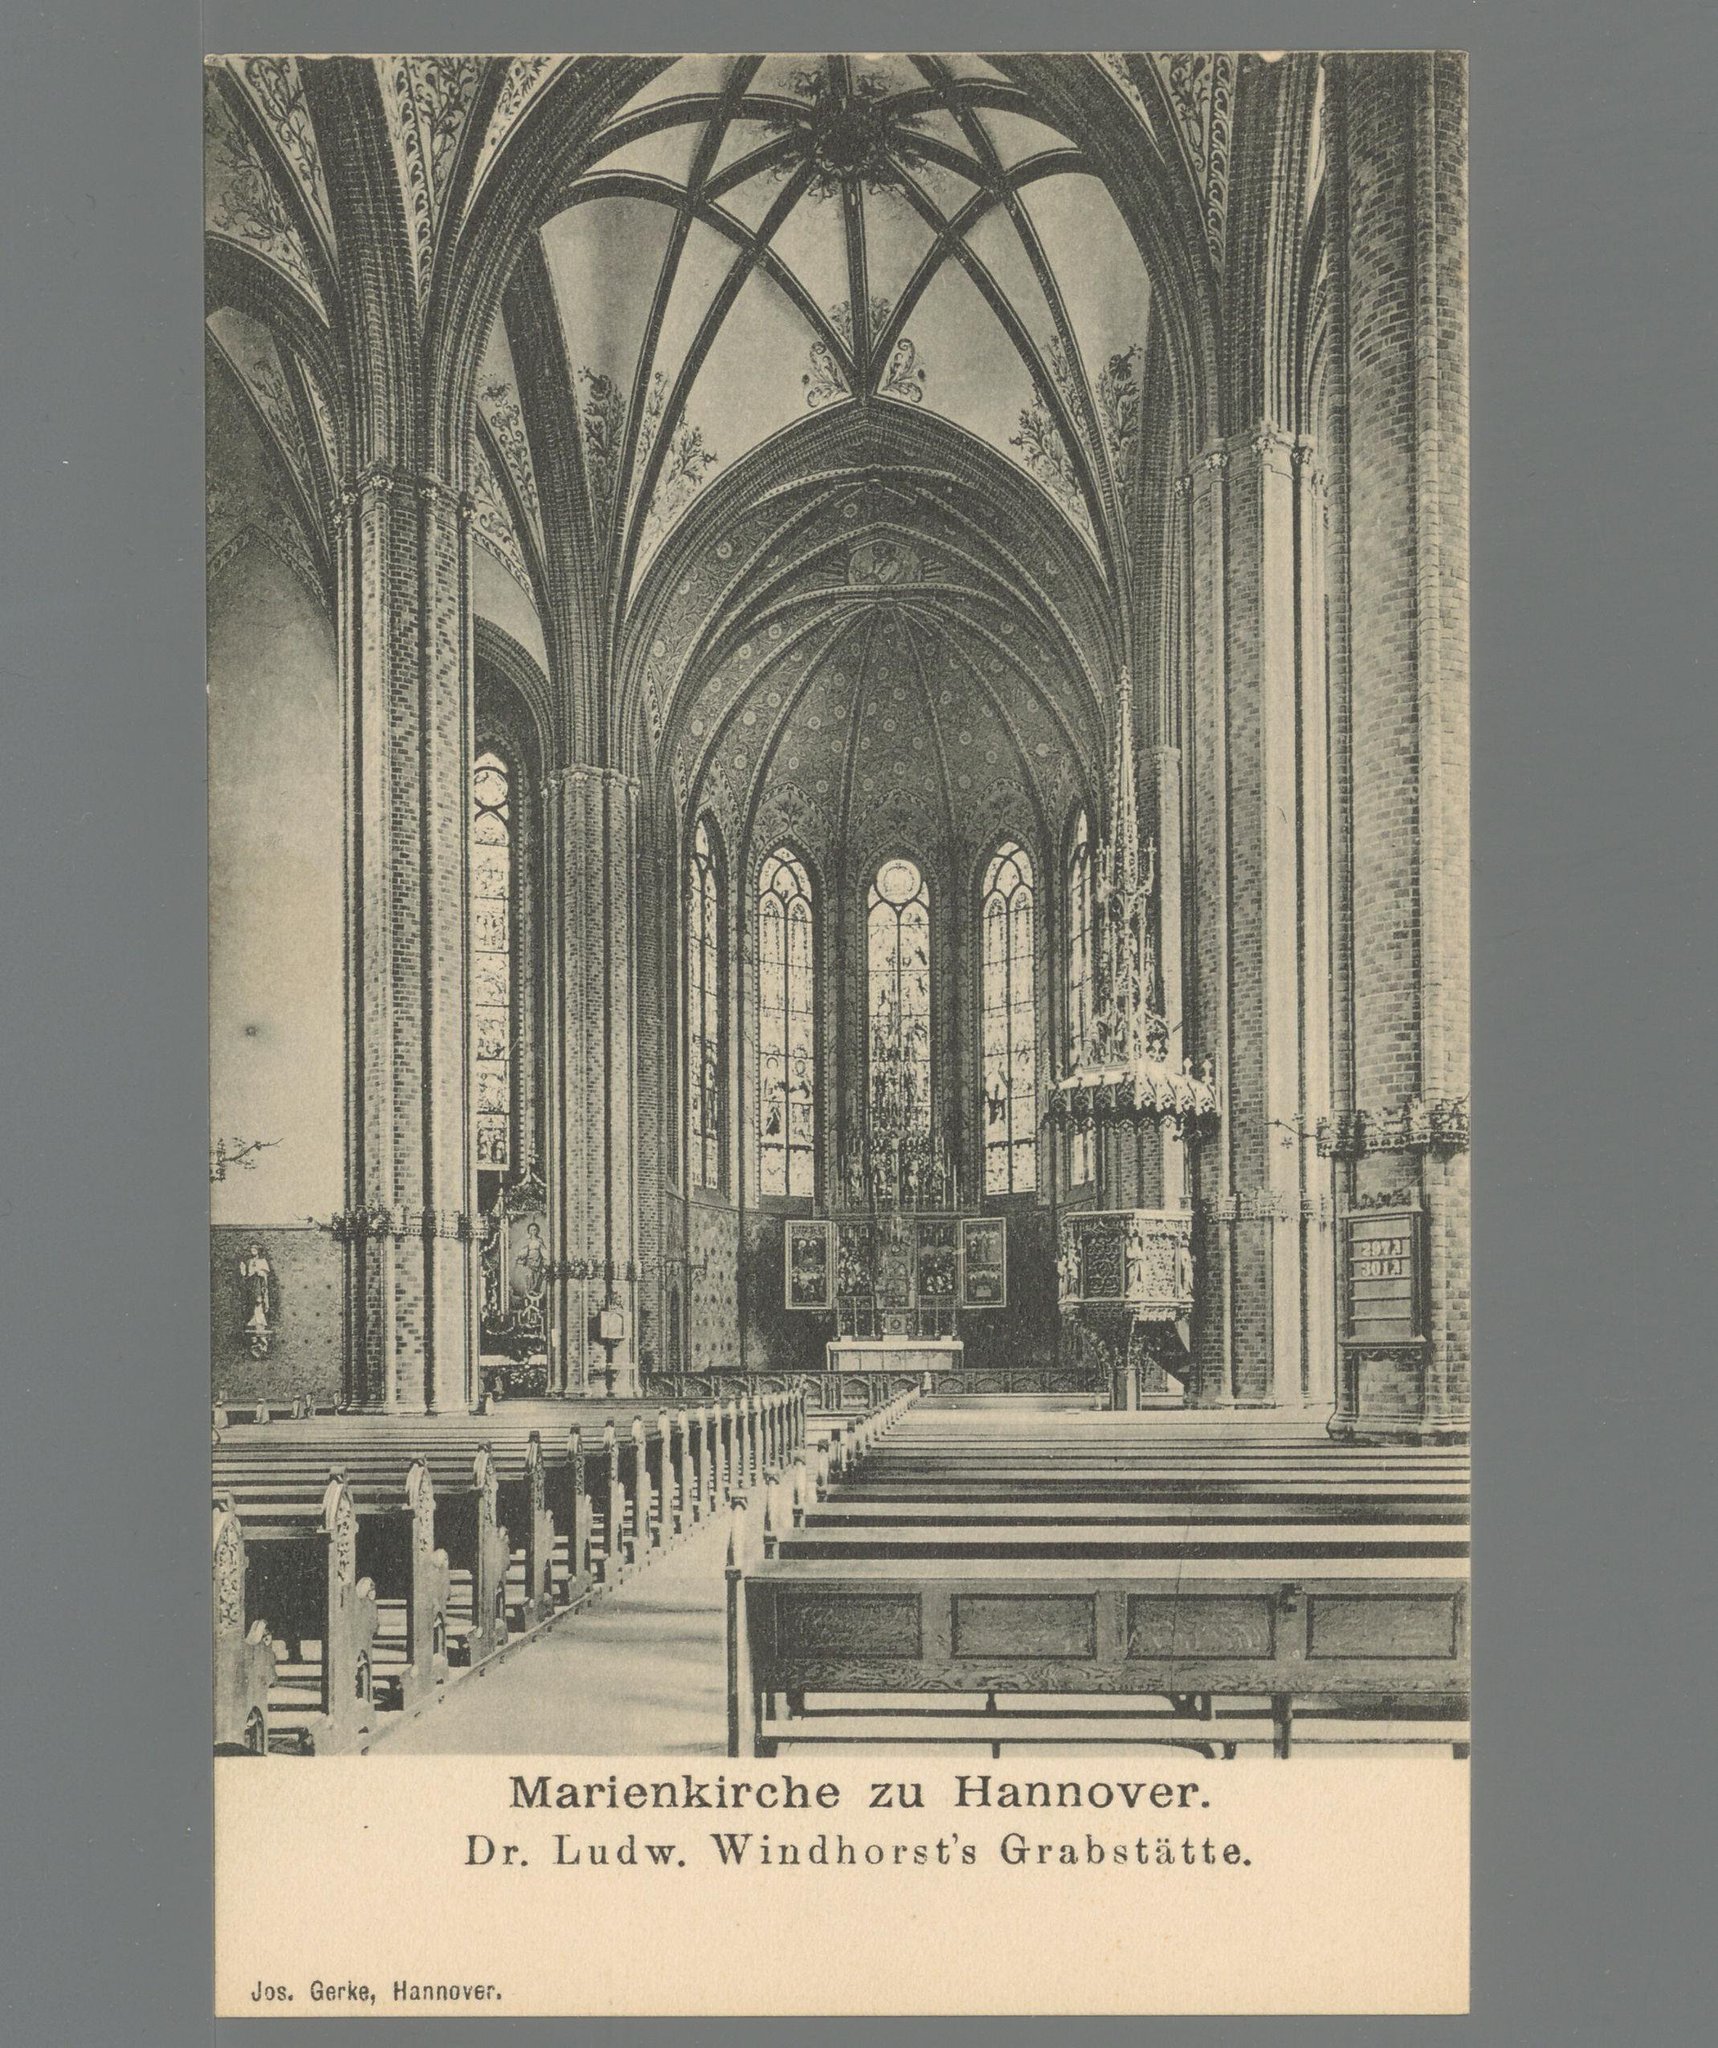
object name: ansichtkaart, prentbriefkaart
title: Marienkirche zu Hannover. Dr. Ludw. Windhorst's Grabstätte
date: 1905-1930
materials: cardboard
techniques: photograph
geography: hannover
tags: interior of church, pulpit, ambo, chancel, altar with altar-piece